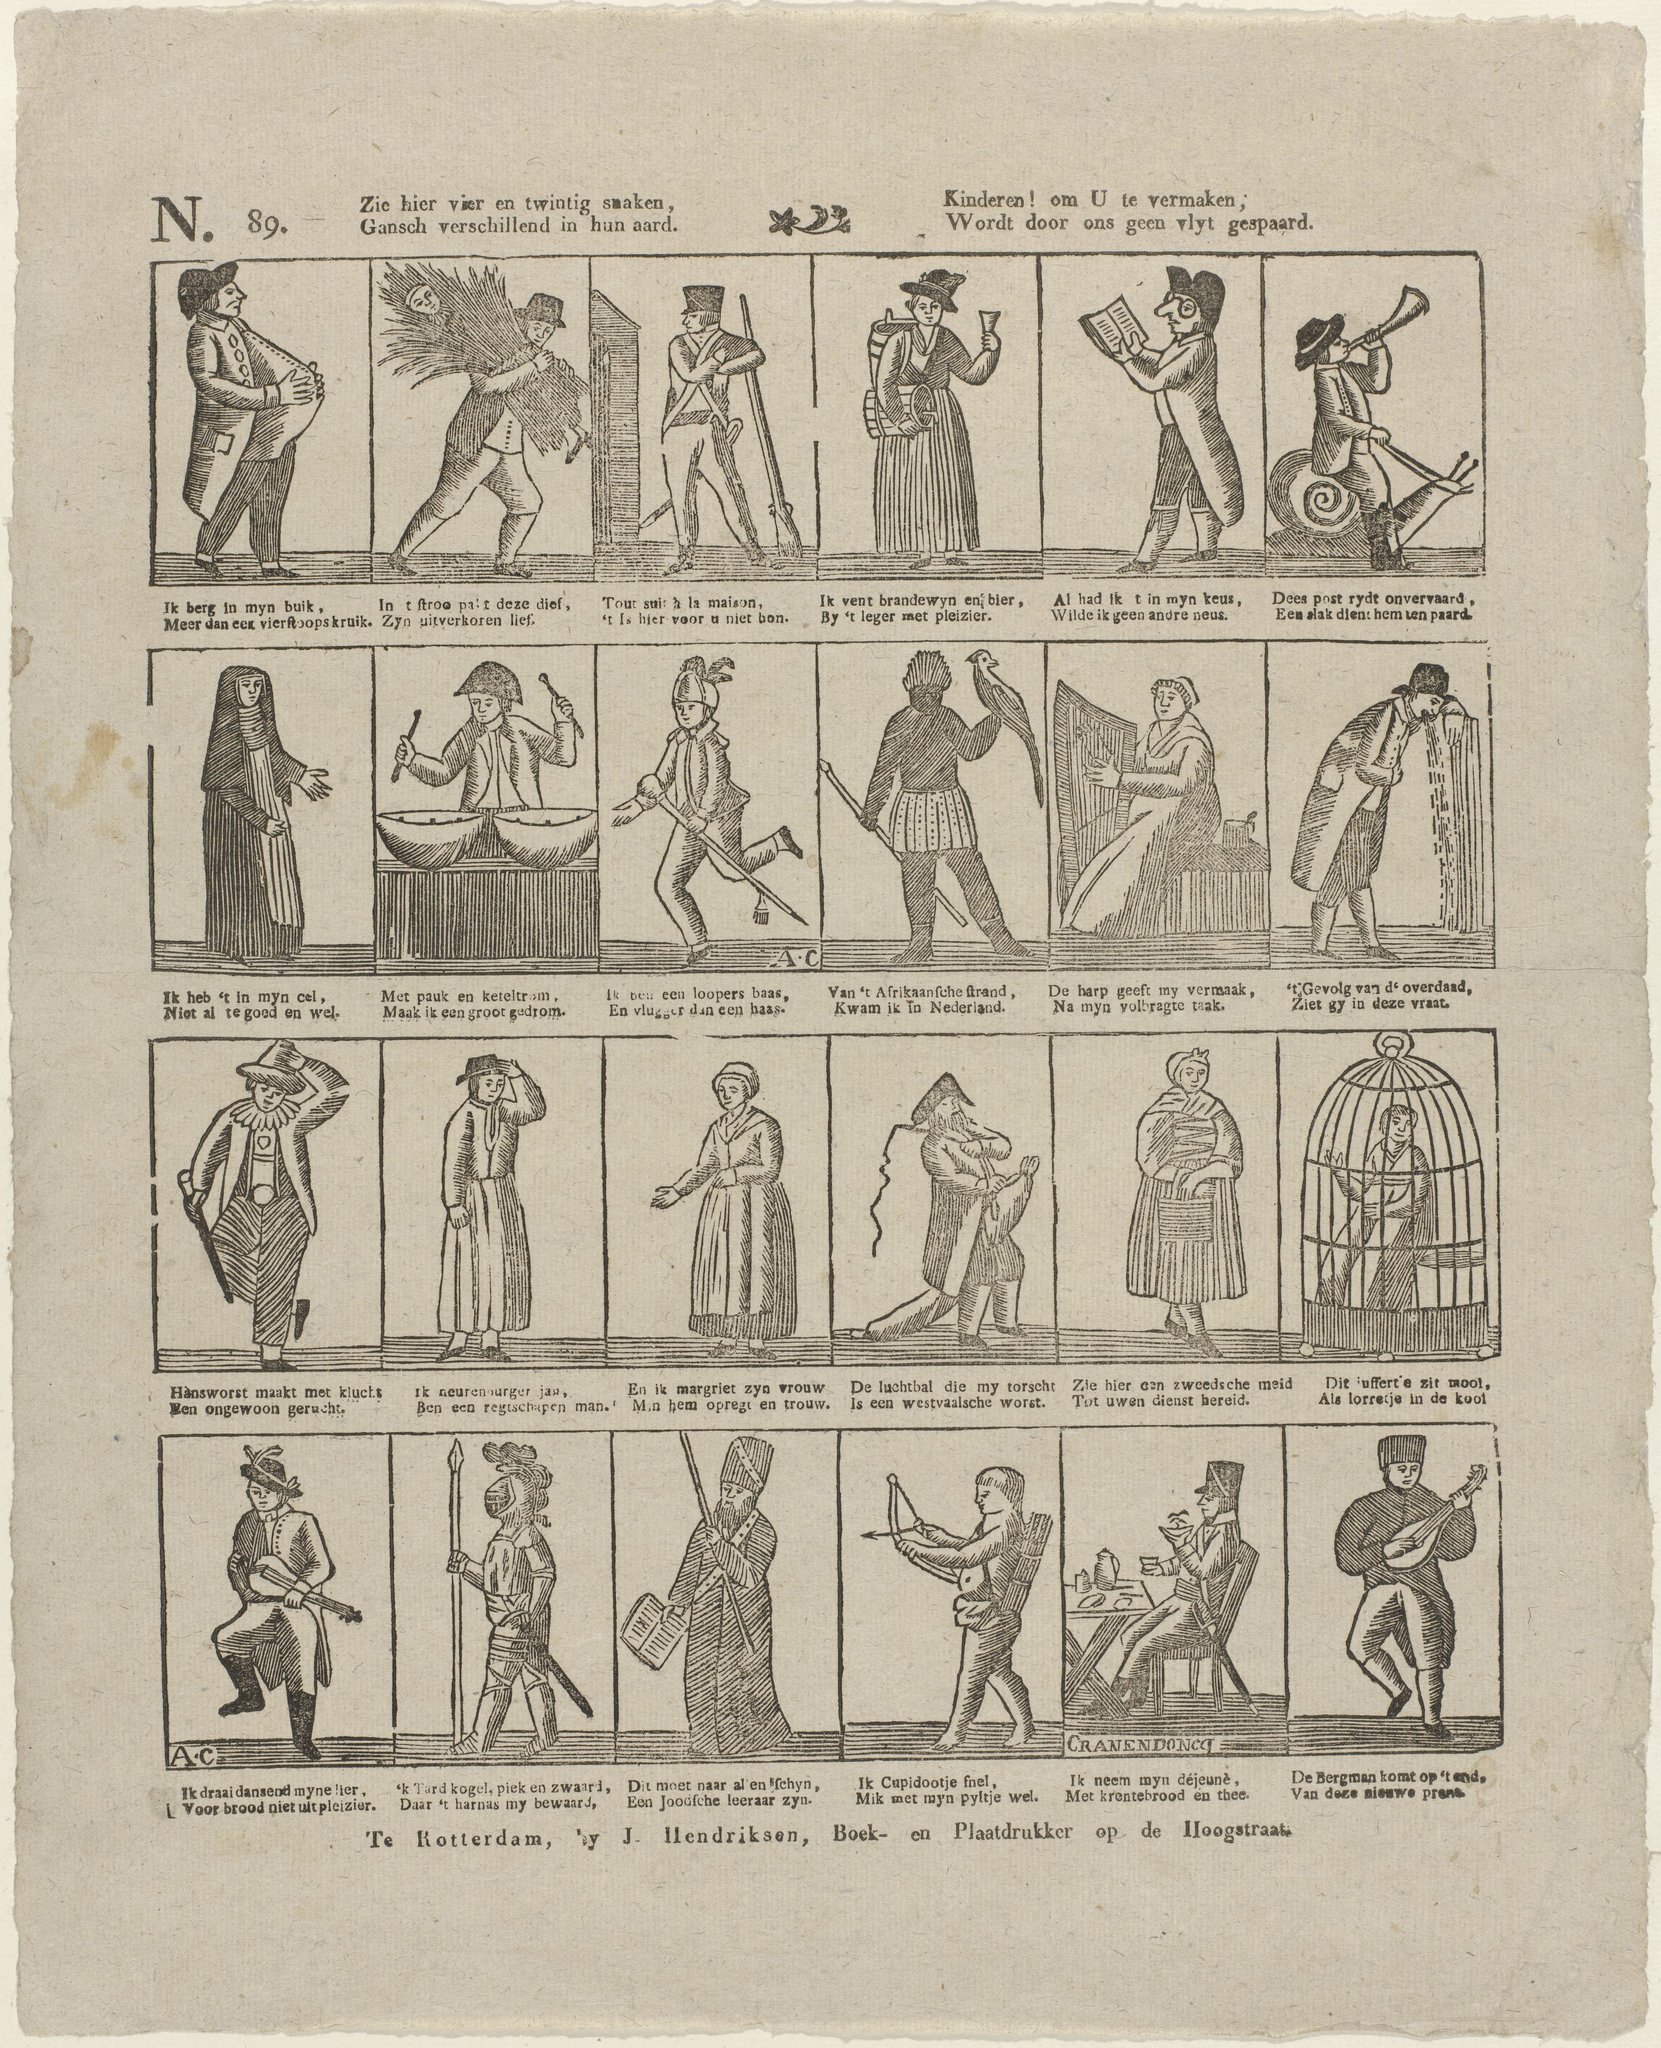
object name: popular print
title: Zie hier vier en twintig snaken, / Gansch verschillend in hun aard. / Kinderen! om u te vermaken; / Wordt door ons geen vlyt gespaard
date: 1781-1828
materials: paper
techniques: letterpress printing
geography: rotterdam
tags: europeans, nun(s), africans, thief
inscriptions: collector's mark: Lugt 2760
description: Blad met 24 voorstellingen van verschillende figuren en bezigheden. Onder elke afbeelding een tweeregelig vers. Genummerd linksboven: N. 89.